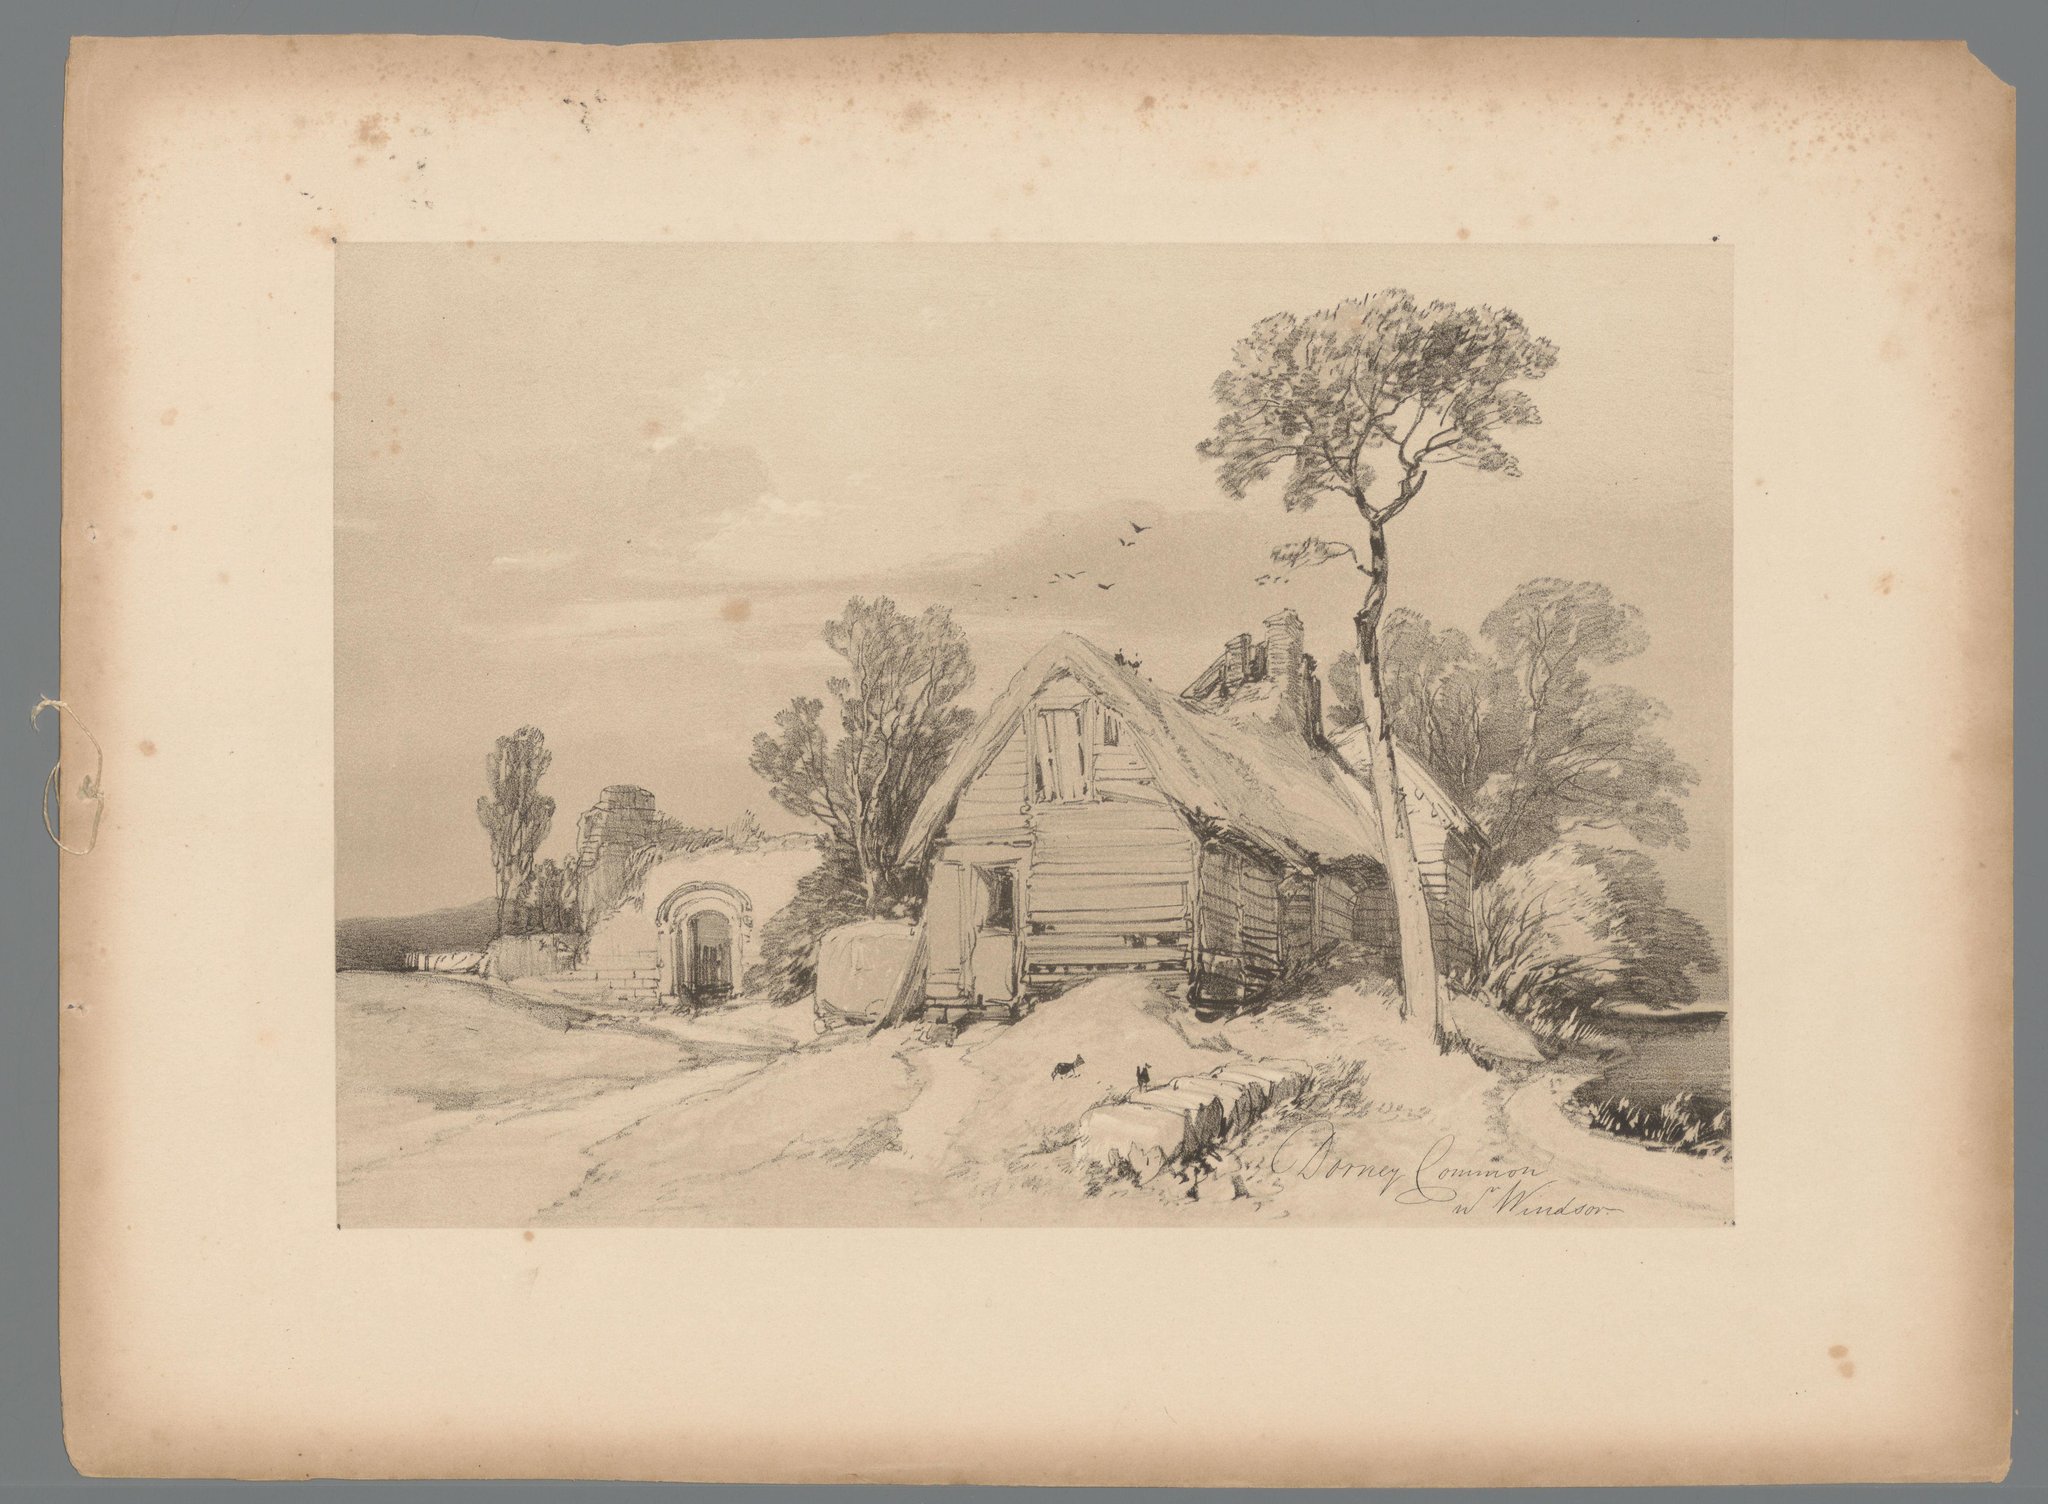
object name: print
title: Harding's drawing book, for the year MDCCCXLI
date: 1841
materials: paper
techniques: tone lithography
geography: london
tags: farm or solitary house in landscape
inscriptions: collector's mark: Lugt 2228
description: Uitgever Charles Tilt (met Bogue) heeft verschillende series uitgegeven over het werk van James Duffield Harding. Deze serie 'Harding's drawing book, for the year MDCCCXLI', bestaat uit zes delen.